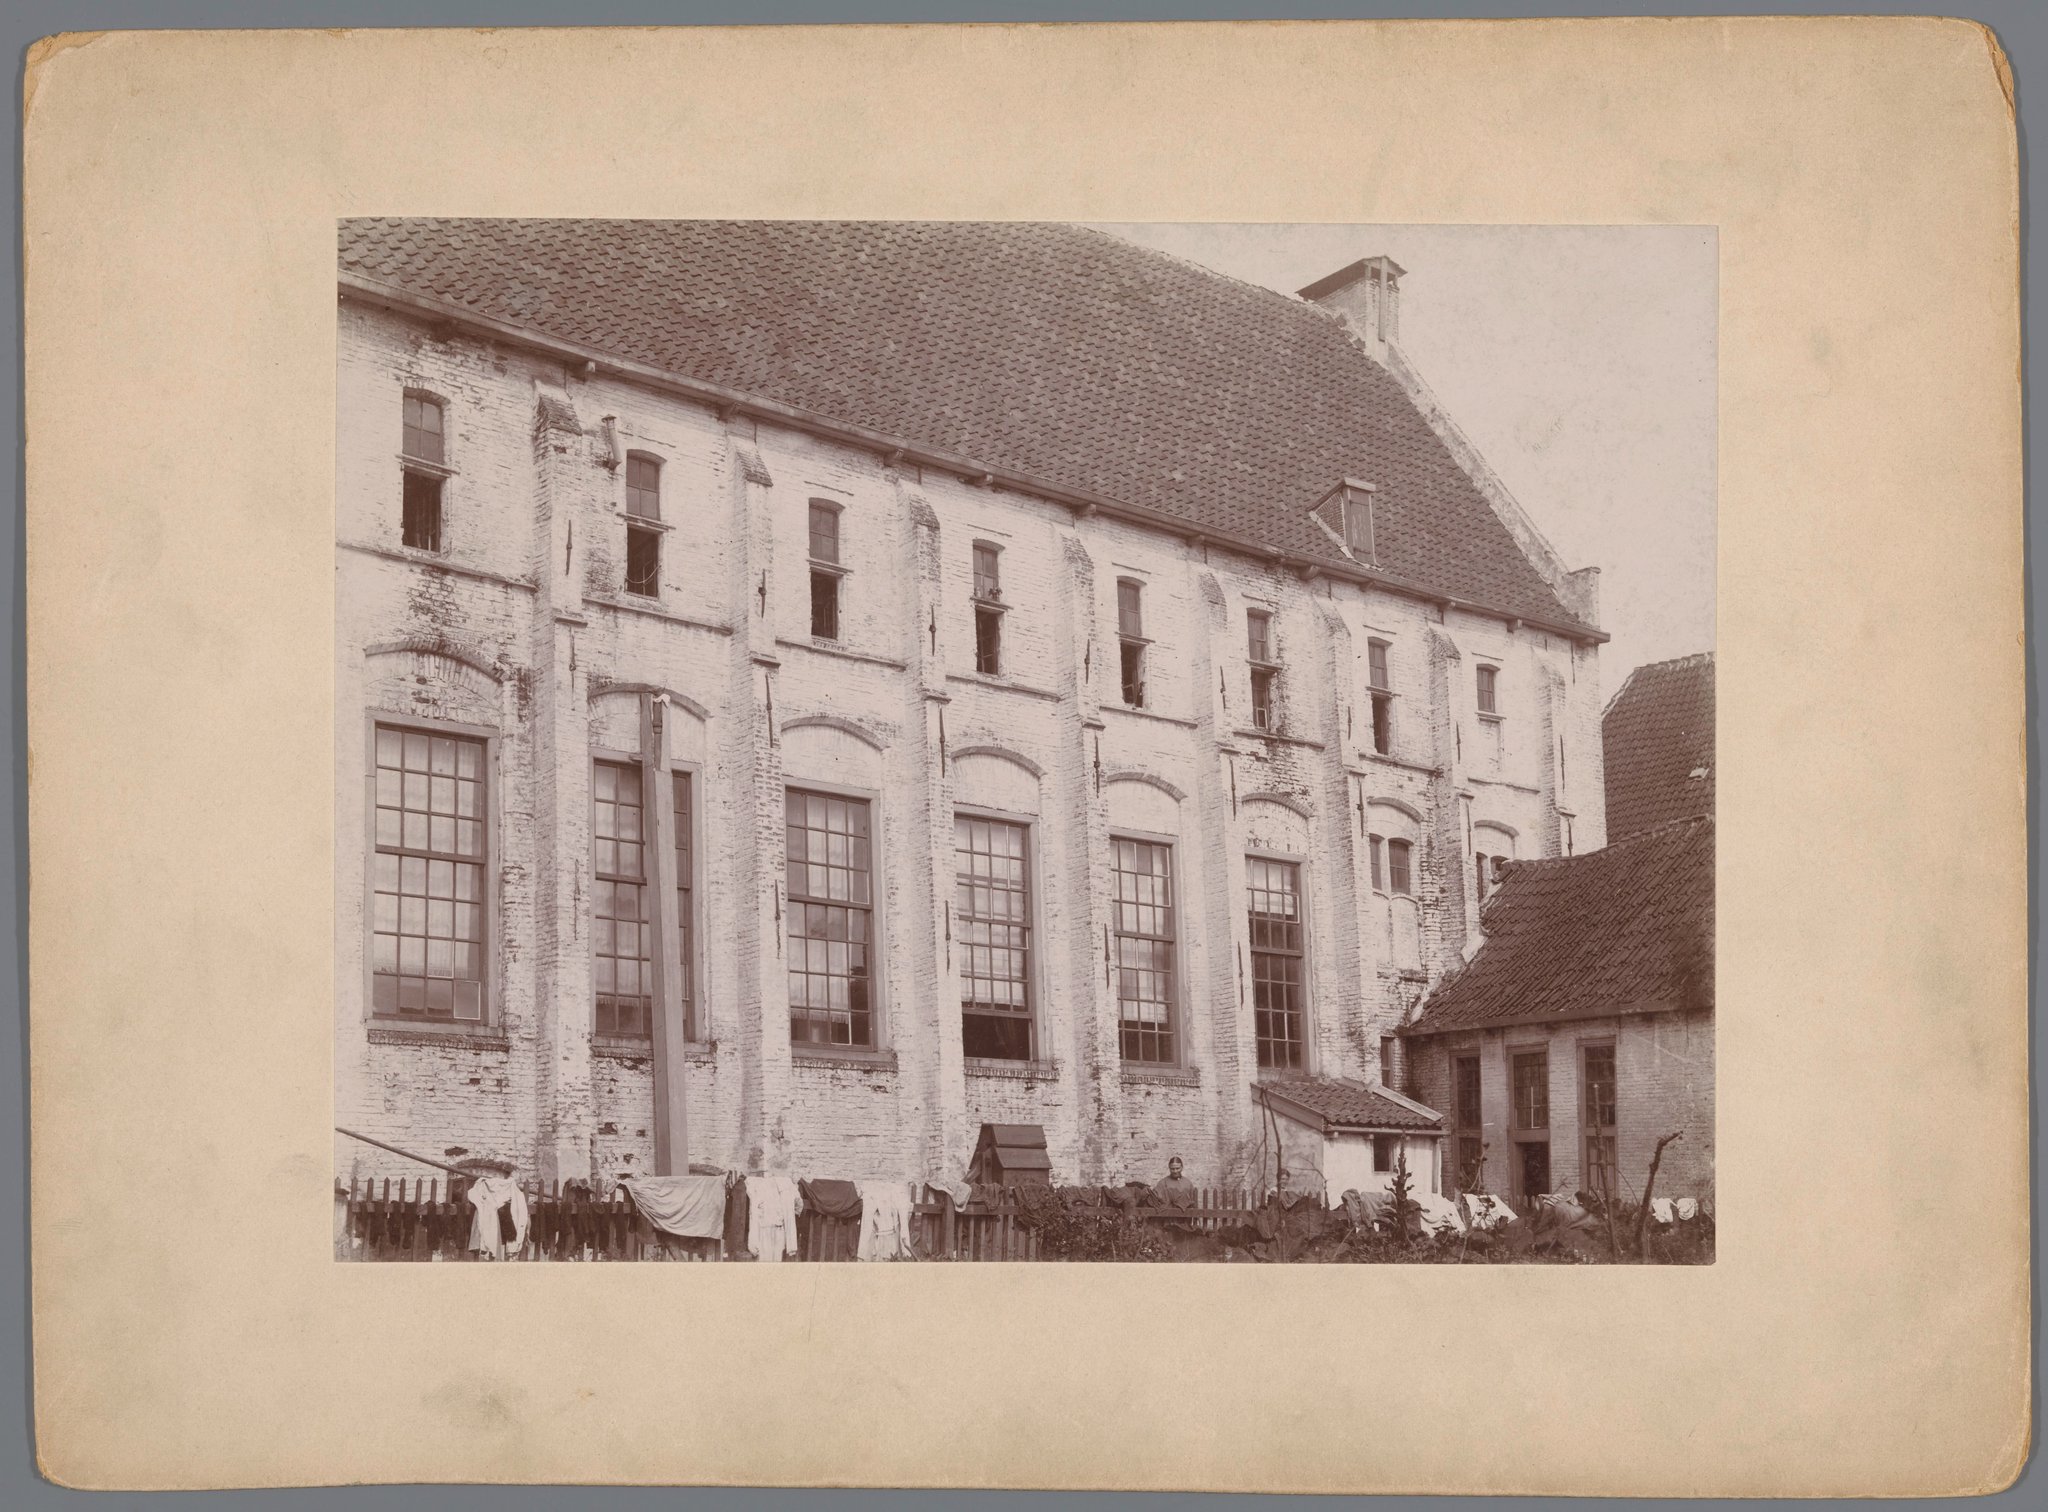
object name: photograph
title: Deel van de gevel van (vermoedelijk) het weeshuis van Kampen, gezien vanaf de binnenplaats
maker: Anonymous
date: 1875-1900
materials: cardboard, photographic support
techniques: daylight paper print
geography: kampen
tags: façade (of house or building), orphanage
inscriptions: inscription: ‘Kampen - gezicht op het weeshuis van af de binnenplaats’, collector's mark: Lugt 3937